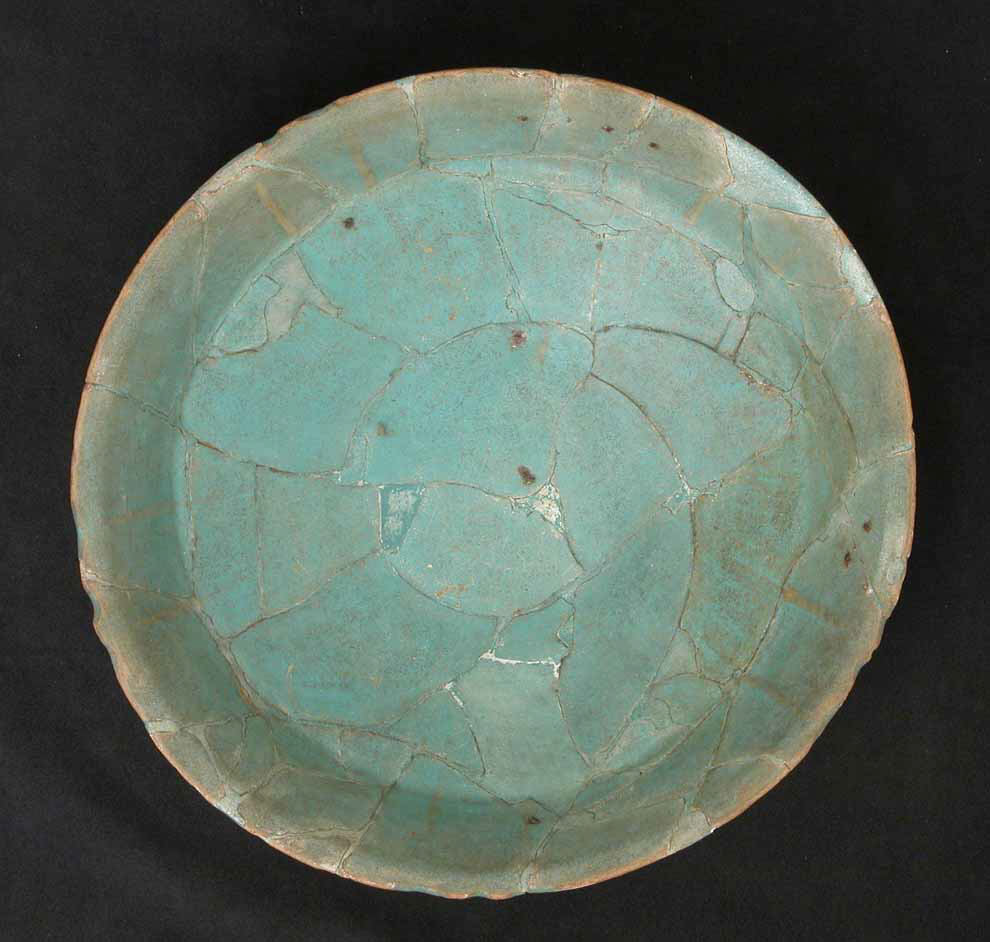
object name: bowl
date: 701-900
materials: earthenware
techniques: glazing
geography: iran